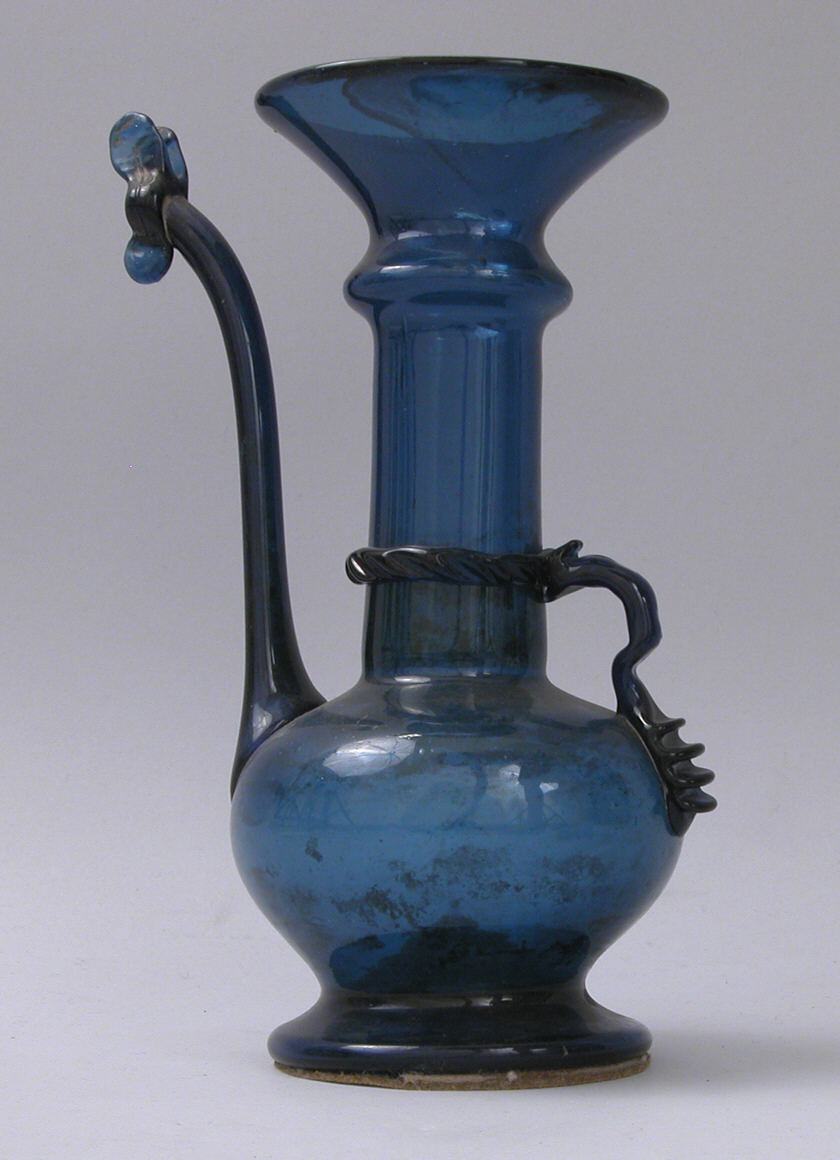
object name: ewer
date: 1801-1900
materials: glass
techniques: glassblowing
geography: iran